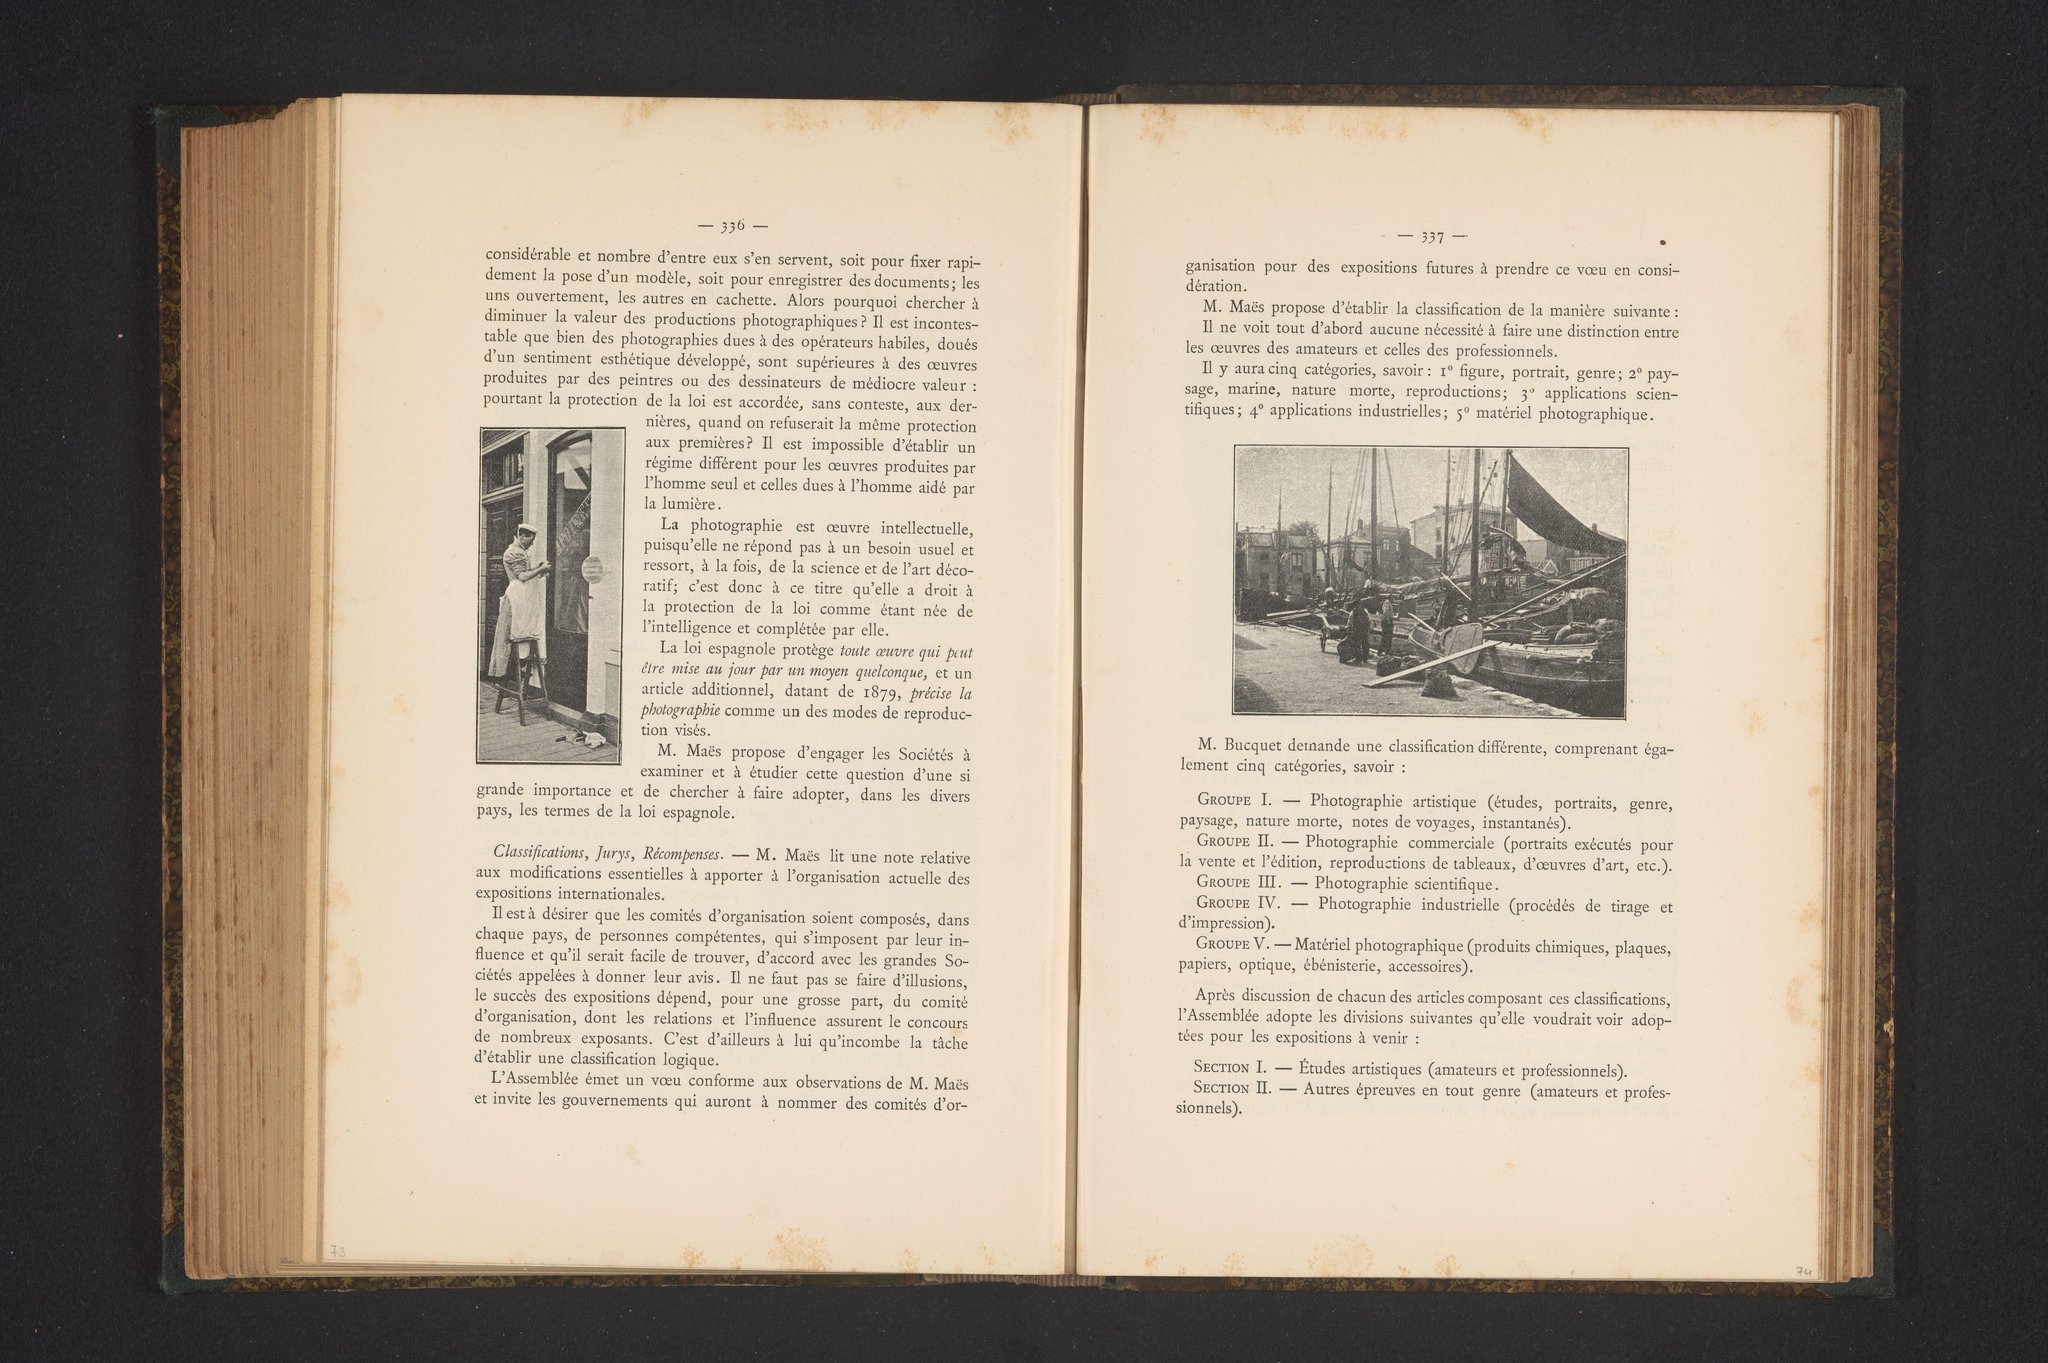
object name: photomechanical print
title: Vrouw maakt de ramen van een winkel schoon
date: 1890-1895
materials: paper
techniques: autotype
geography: rotterdam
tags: window-cleaning, adult woman, shop-window, show-window, rotterdam